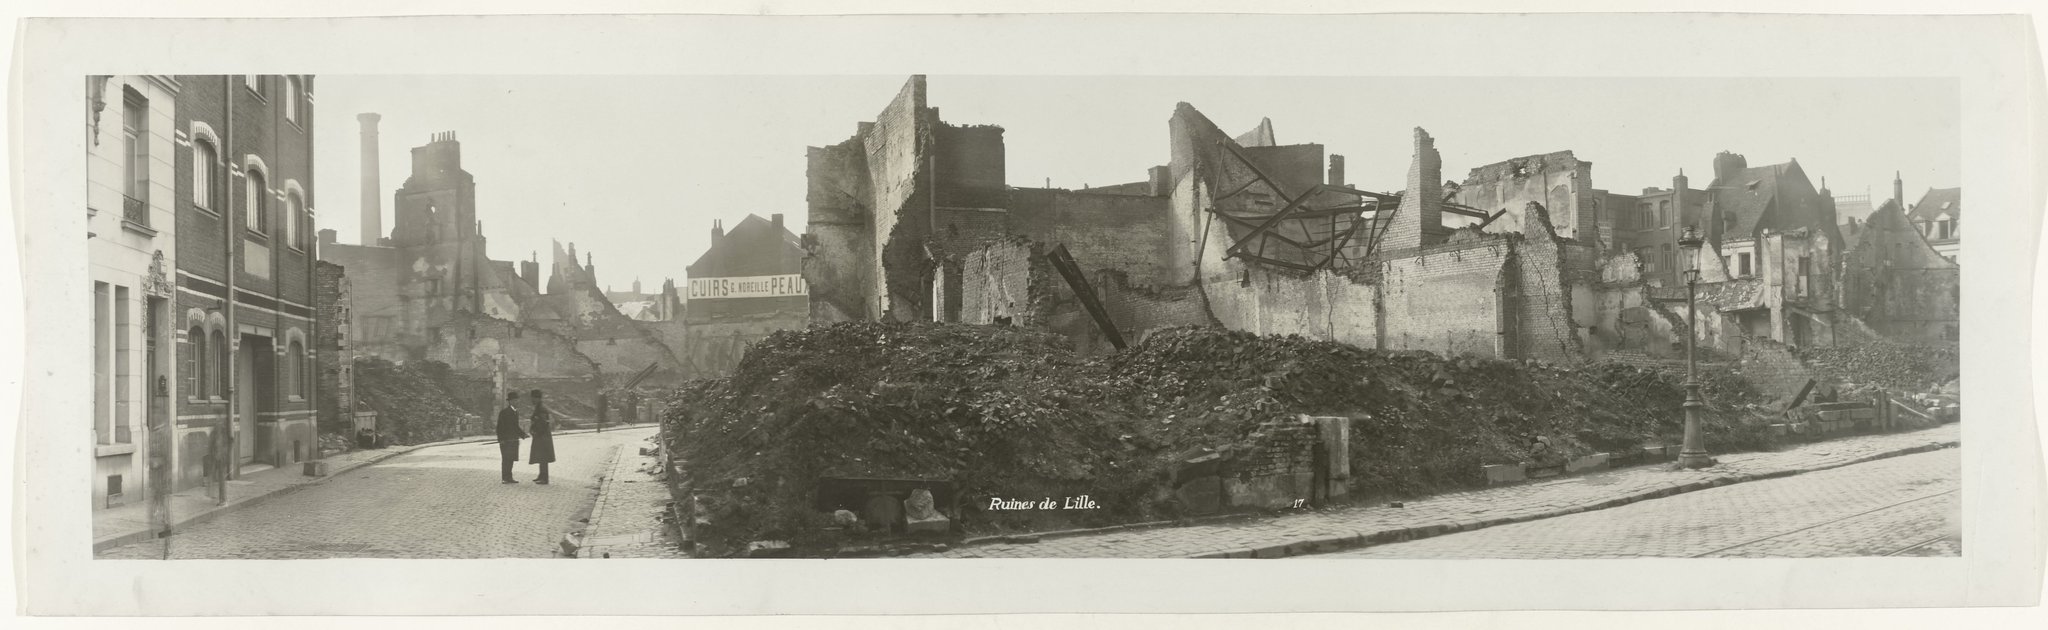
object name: photograph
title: Oorlogsschade in Lille (Frankrijk) na afloop van de Eerste Wereldoorlog ('Ruines de Lille')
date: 1918-1919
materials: photographic support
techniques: gelatin silver print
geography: lille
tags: devastated, ruined place or city (~ warfare), lille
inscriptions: title: ‘Ruines de Lille. // 17’